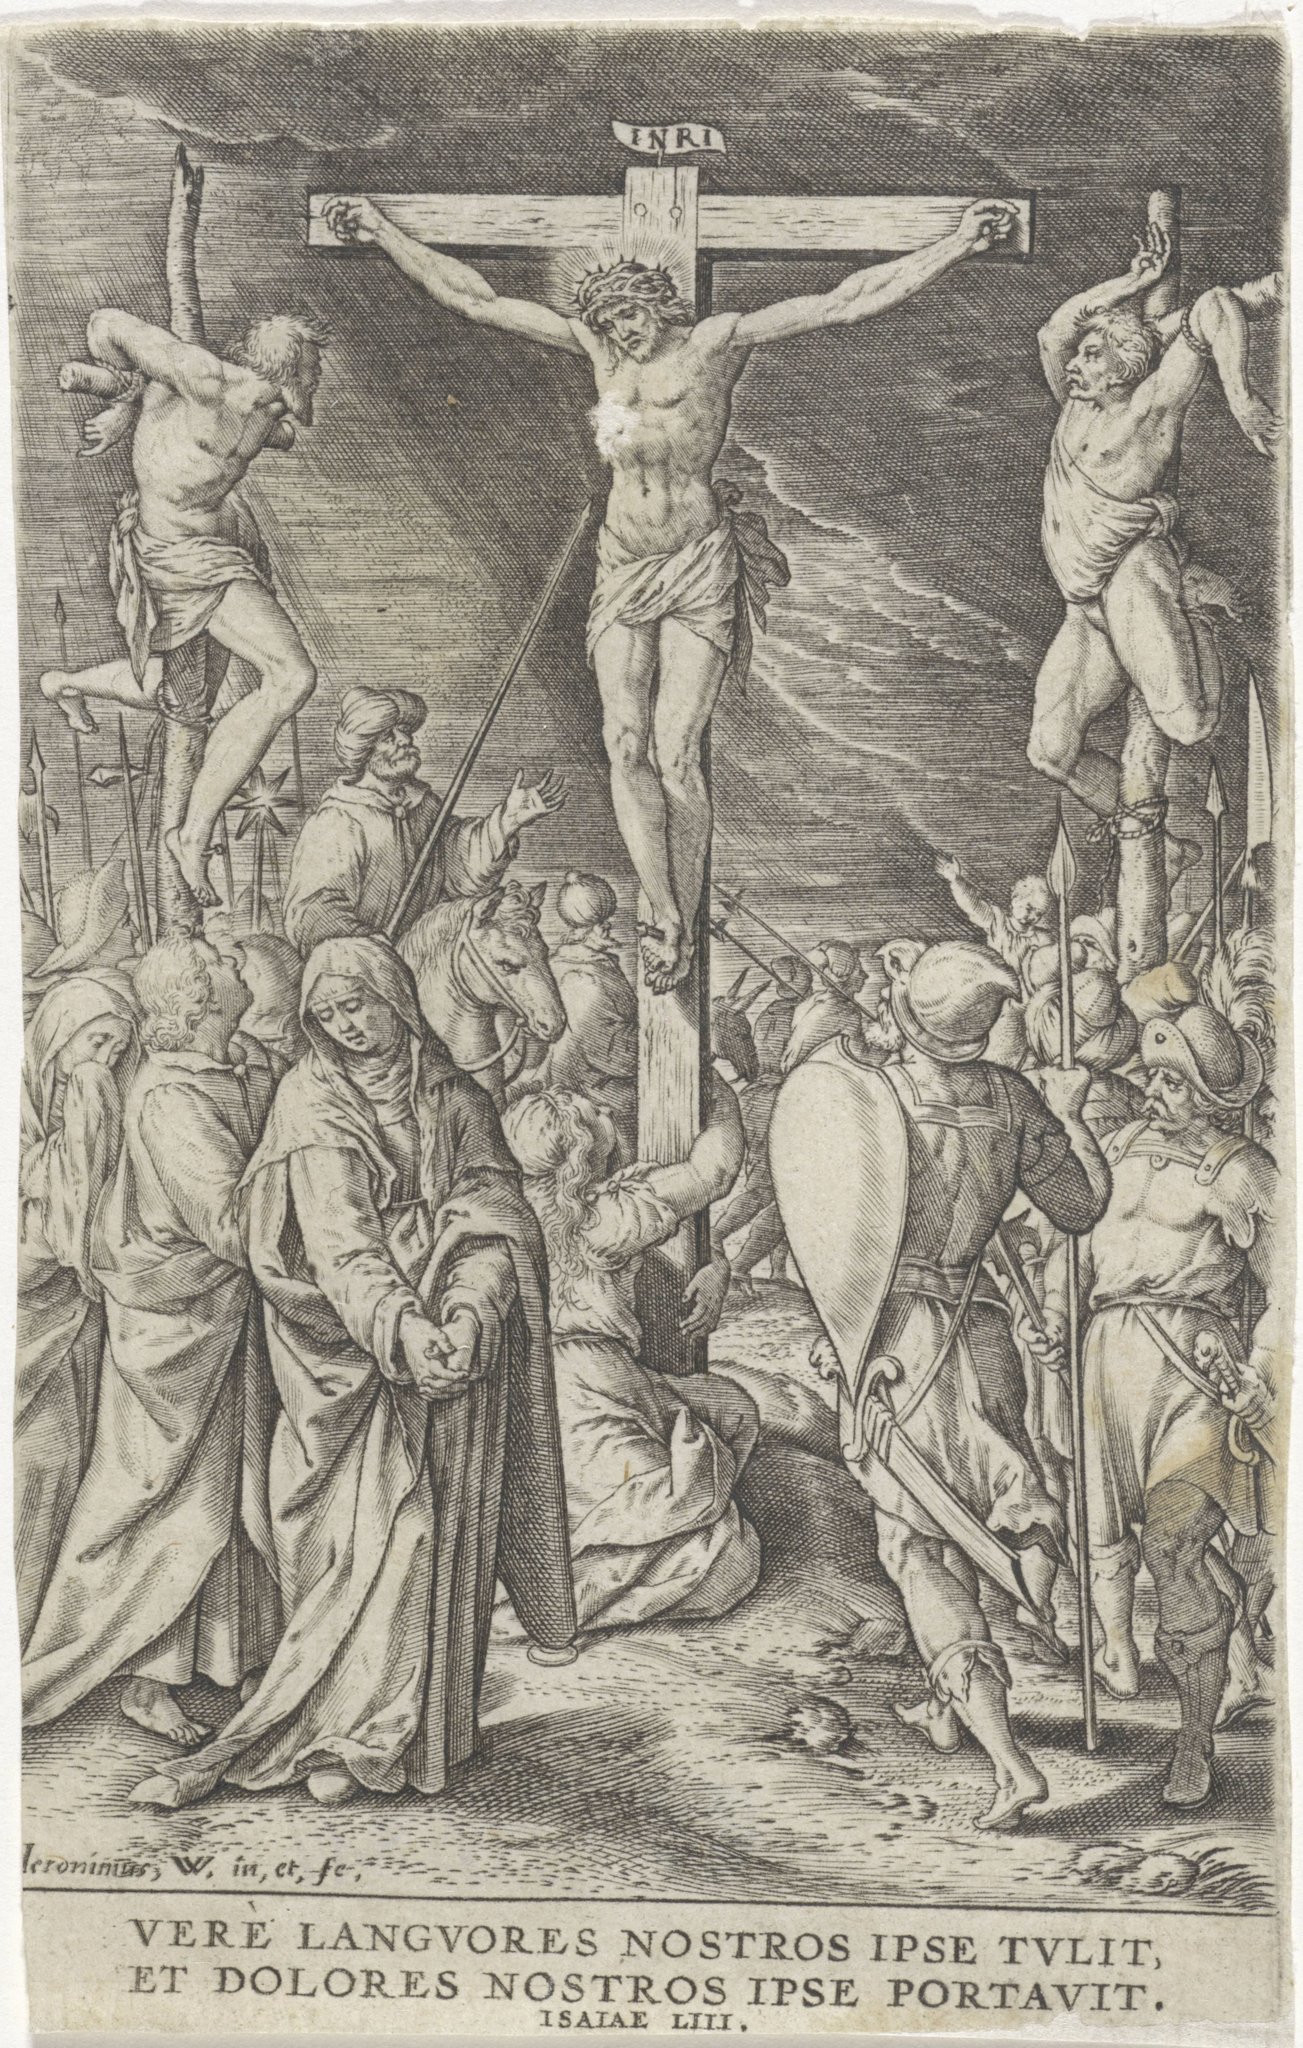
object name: print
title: Kruisiging van Christus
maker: hieronymus wierix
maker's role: draughtsman, print maker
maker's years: 1553-1619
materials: paper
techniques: engraving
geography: antwerp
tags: longinus pierces christ's side with a lance, the crucifixion of christ: christ's death on the cross; golgotha (matthew 27:45-58; mark 15:33-45; luke 23:44-52; john 19:25-38)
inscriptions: collector's mark: Lugt 2228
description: Kruisdood van Christus op Golgota. Christus hangt aan het kruis, aan weerszijden hangen de samen met Christus gekruisigde misdadigers. Longinus staat op het punt zijn lans in de zijde van Christus te steken. Maria Magdalena treurt aan de voet van het kruis. Op de voorgrond Maria. In de marge een tweeregelig Bijbelcitaat uit Jes. 53.